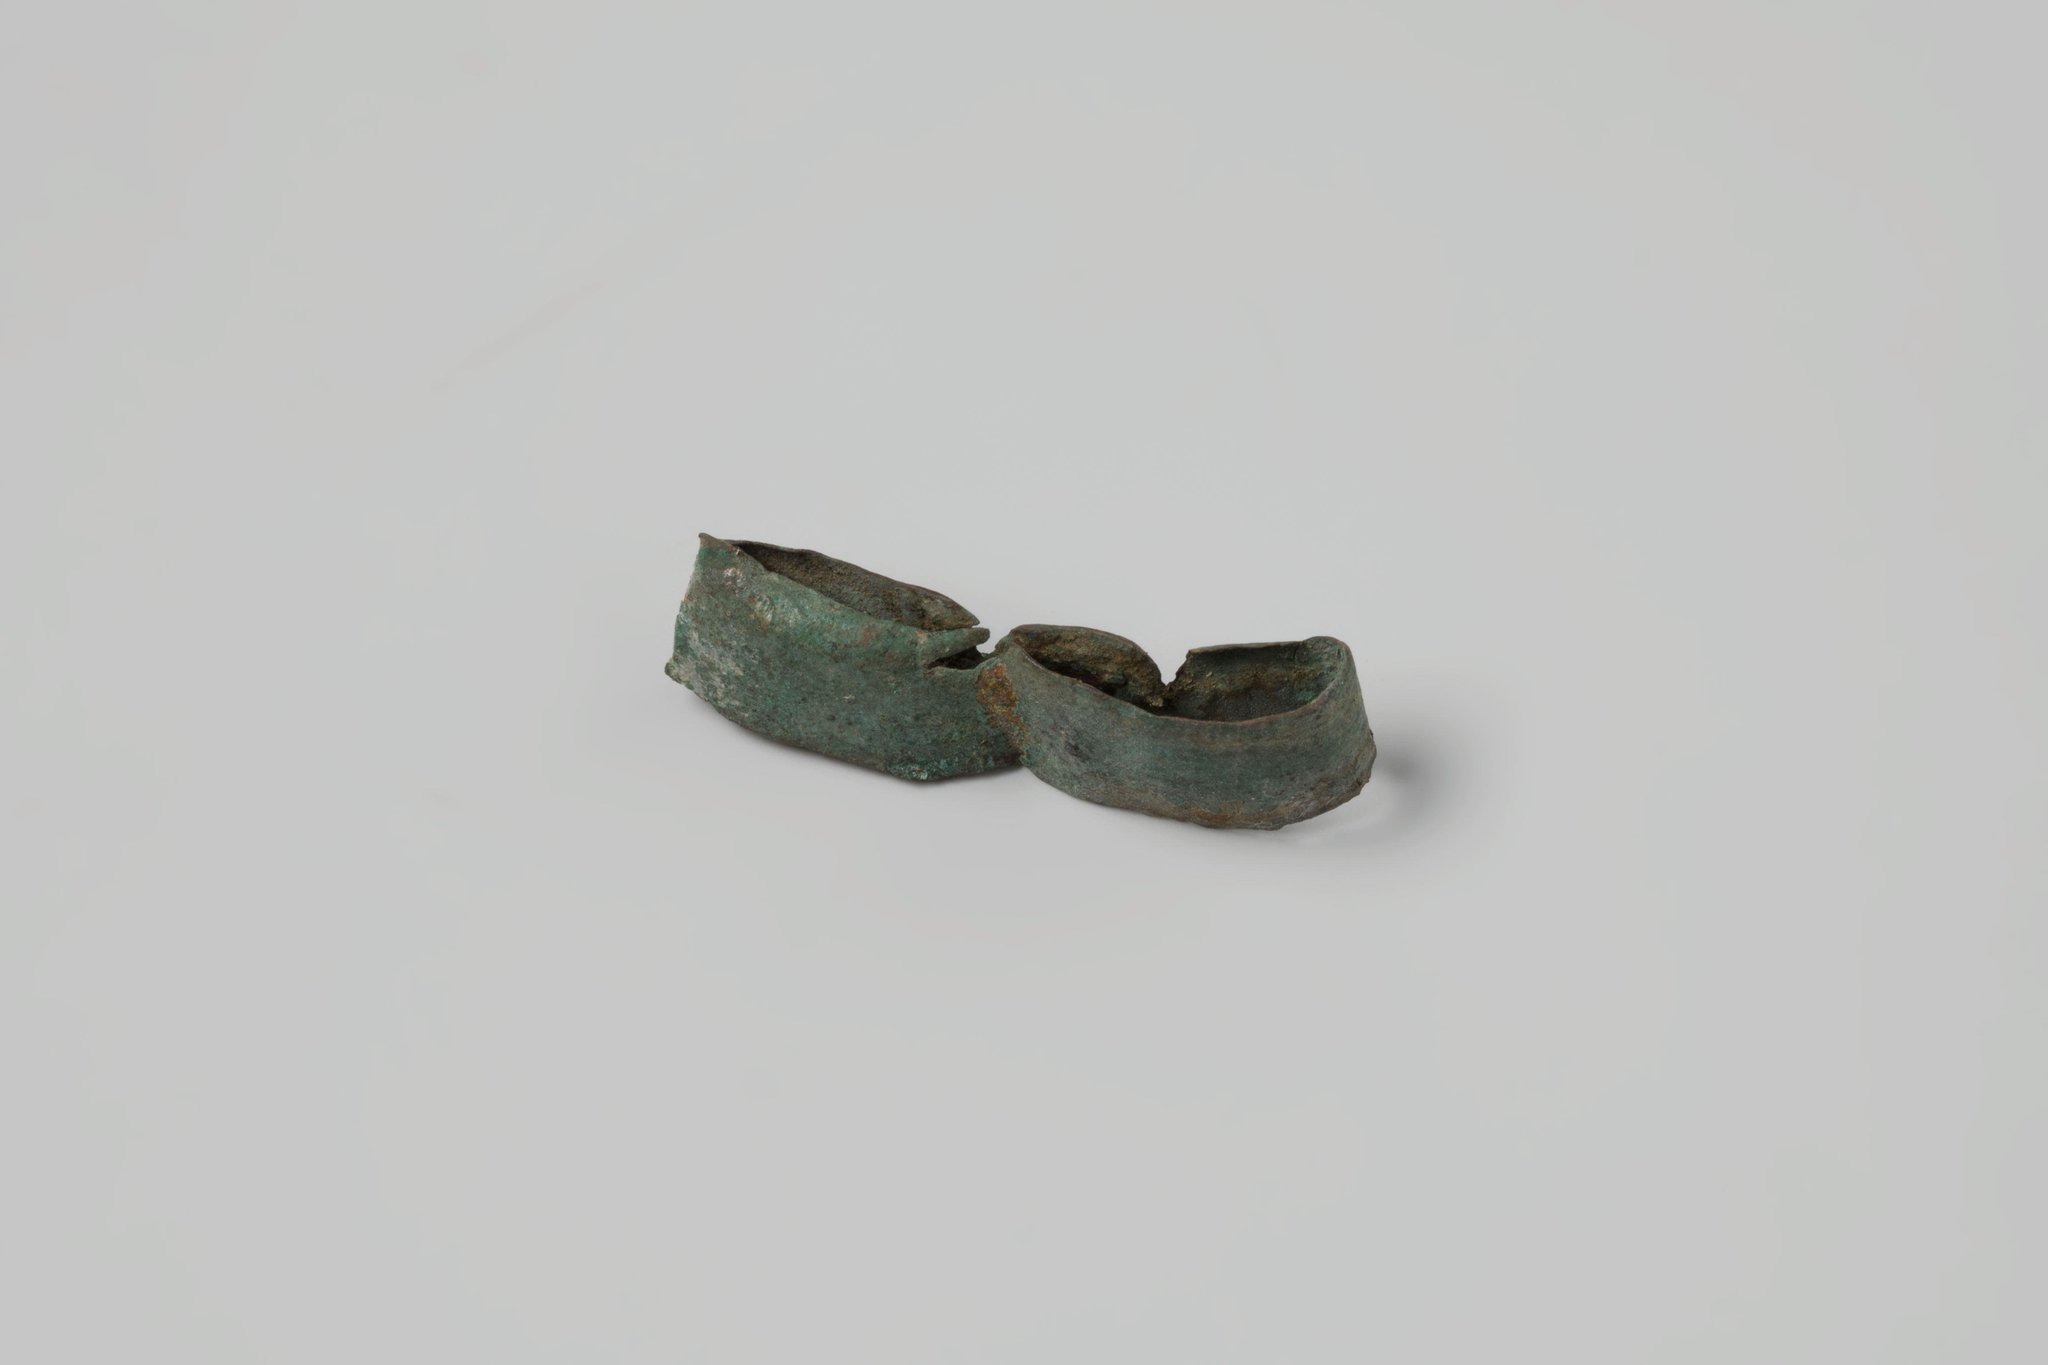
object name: ferrule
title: Messenheftring uit het wrak van de Oost-Indiëvaarder Hollandia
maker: Anonymous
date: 1700-1743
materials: copper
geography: netherlands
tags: verenigde oostindische compagnie, hollandia (schip), annet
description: Knife-handle, ferrule; id. NG 1980-27H426.